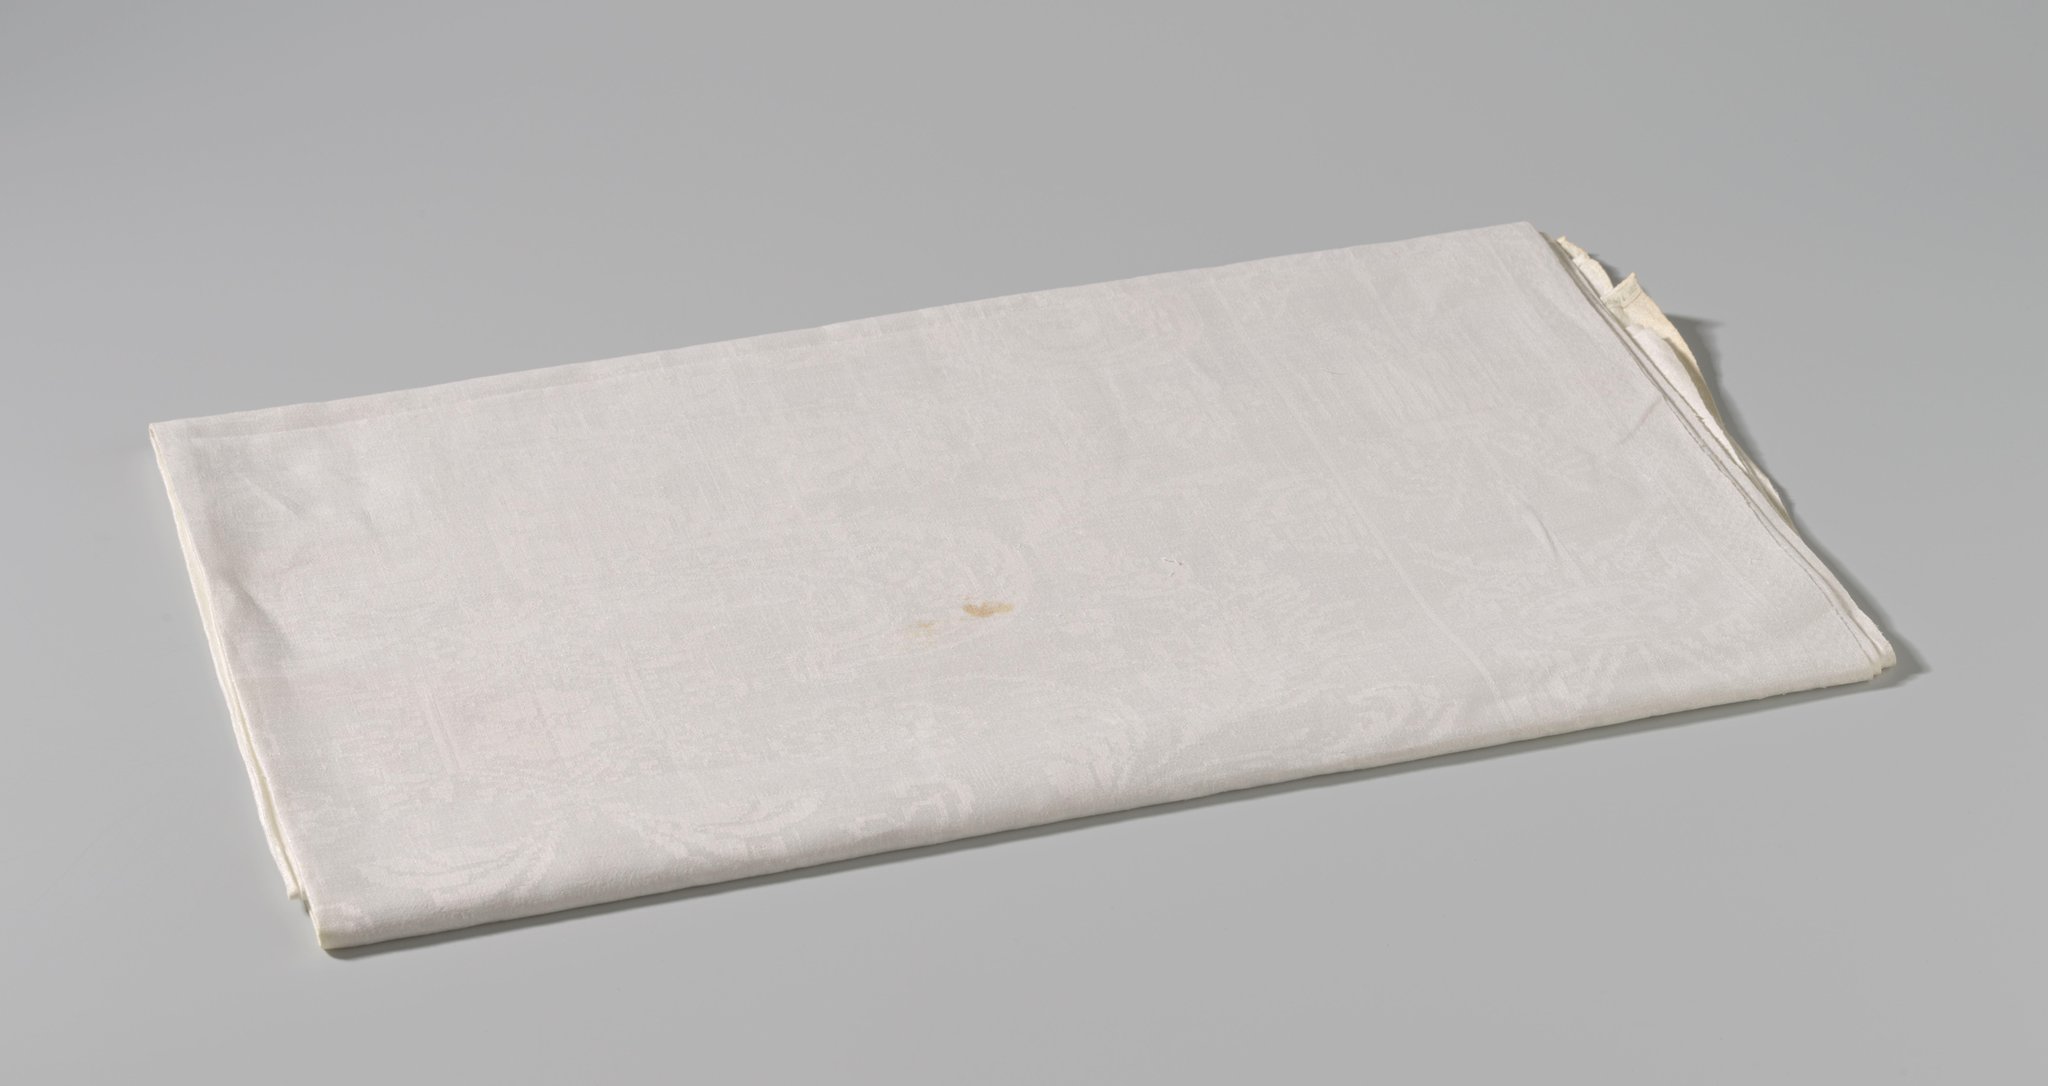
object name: tablecloth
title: Tafellaken met het wapen van Cornelis Hop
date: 1700-1724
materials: linen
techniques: damask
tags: amsterdam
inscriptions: mark: ‘H.’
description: Tafellaken van linnendamast met het wapen van Cornelis Hop. Middenveld: symmetrische patroon van veelsoortige voluutranken met op de knooppunten geblokte verdikkingen. Daartussen een liggend ovaal schild met een wapen van Cornelis Hop (1685-1762), ambassadeur aan het hof van koning Lodewijk XV van Frankrijk: gevierendeeld, 1 en 4 kopvogel staande op bol (de vogel van 1 omgewend, die van 4 omziend); 2 en drie twee afgewende vleugels. Hartschild gedeeld: 1 een dwarsbalk, 2 rechts een vijfpuntige ster, links een gewende wassenaar. Het schild gedekt met vijfbladerige kroon. Schildhouders: rechts een afgewende adelaar, links een afgewende leeuw. Randen: wapentrofeeën. Hoeken: een rondas. Rondom blokkenrand.